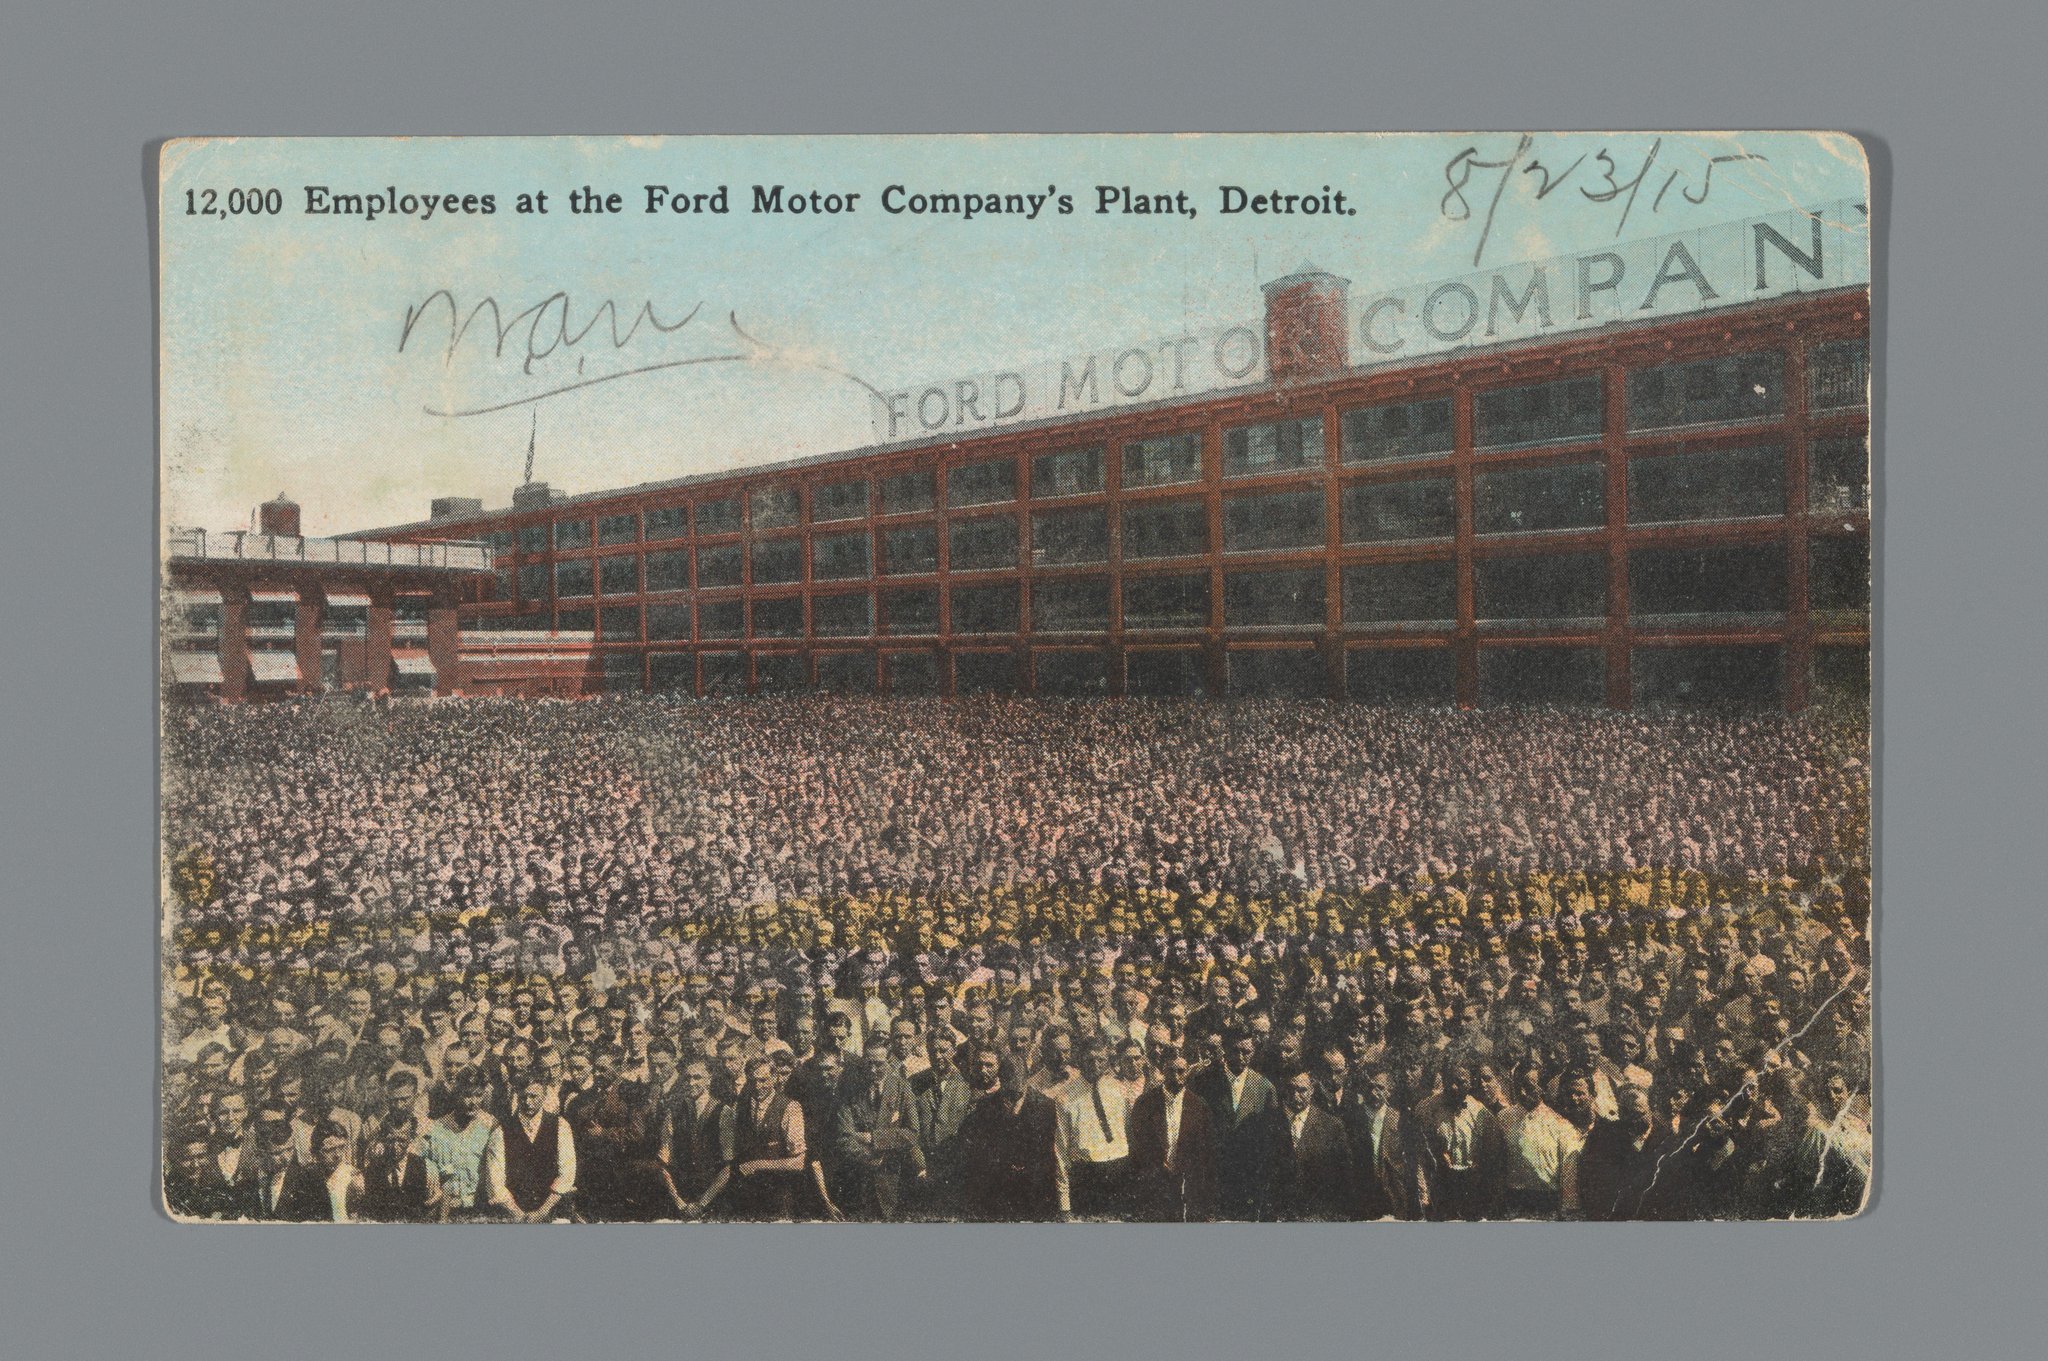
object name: ansichtkaart, prentbriefkaart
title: Groepsportret van de werknemers van de Ford Motor Company, Highland Park Plant, Michigan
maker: Anonymous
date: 1913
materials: paper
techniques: four-color autotype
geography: united states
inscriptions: inscription: ‘Some / crowd / […]. Poststempel 1915’, inscription: ‘12,000 Employees at the Ford Motor Company’s Plant, Detroit.’, inscription: ‘THIS SPACE FOR WRITING’, inscription: ‘8/23/15’